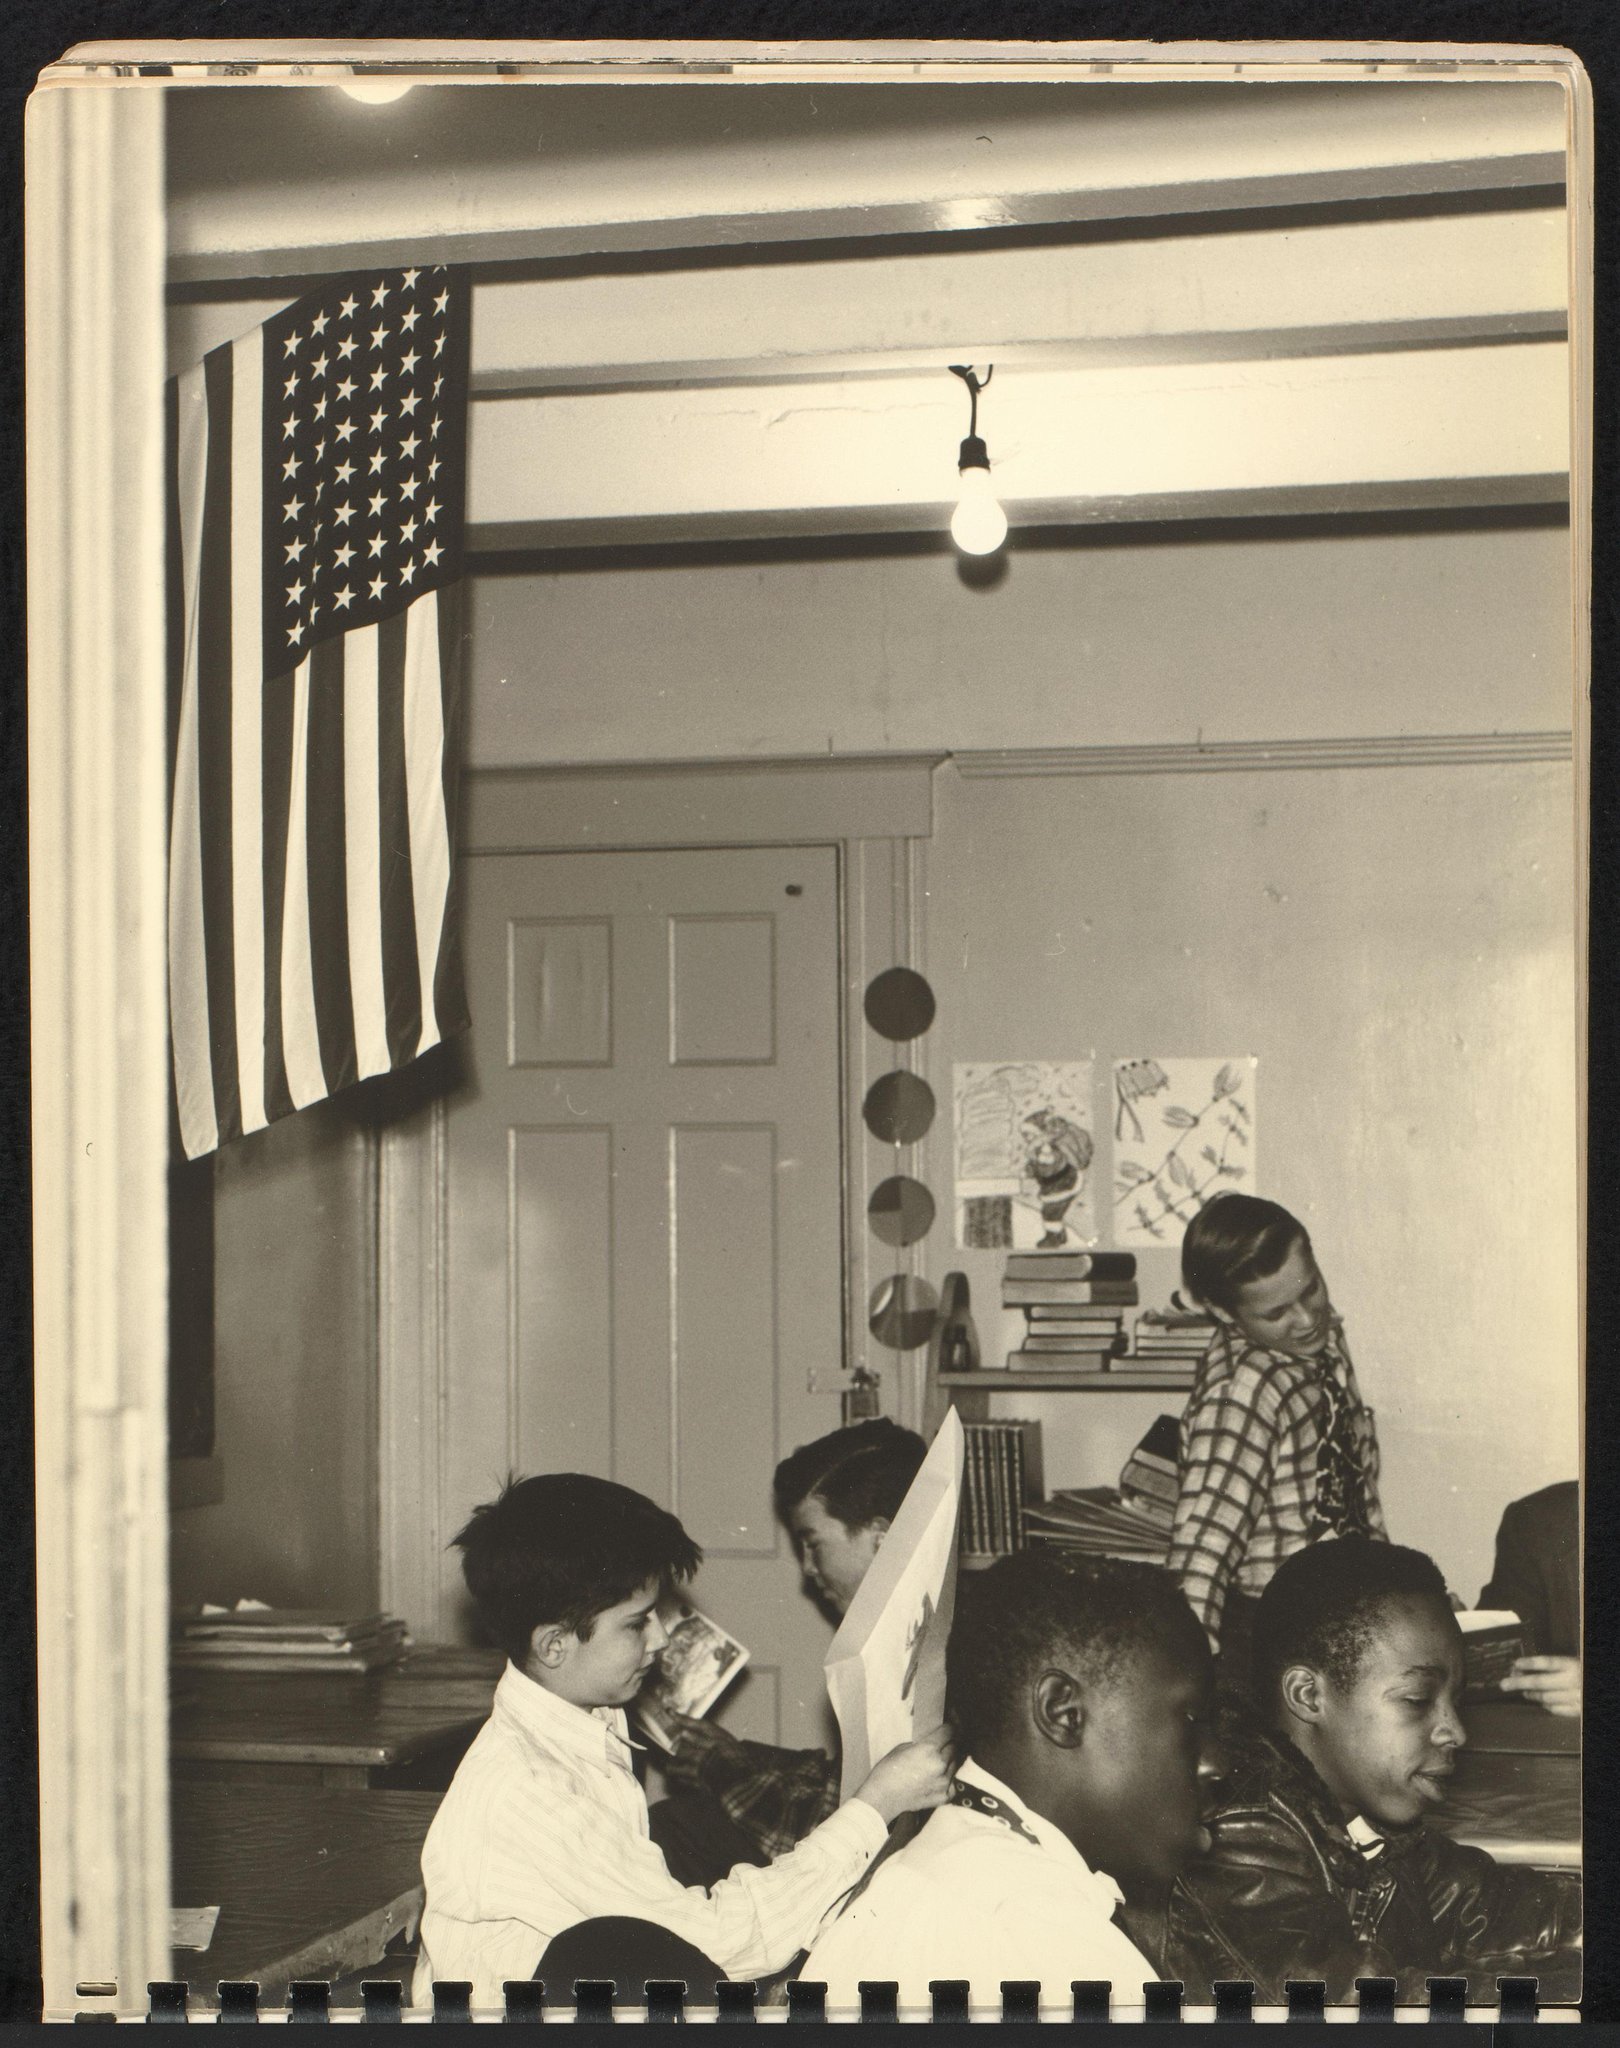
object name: photograph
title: Klaslokaal, met vijf jongens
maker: Anonymous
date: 1950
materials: paper, photographic support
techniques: gelatin silver print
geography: new york city